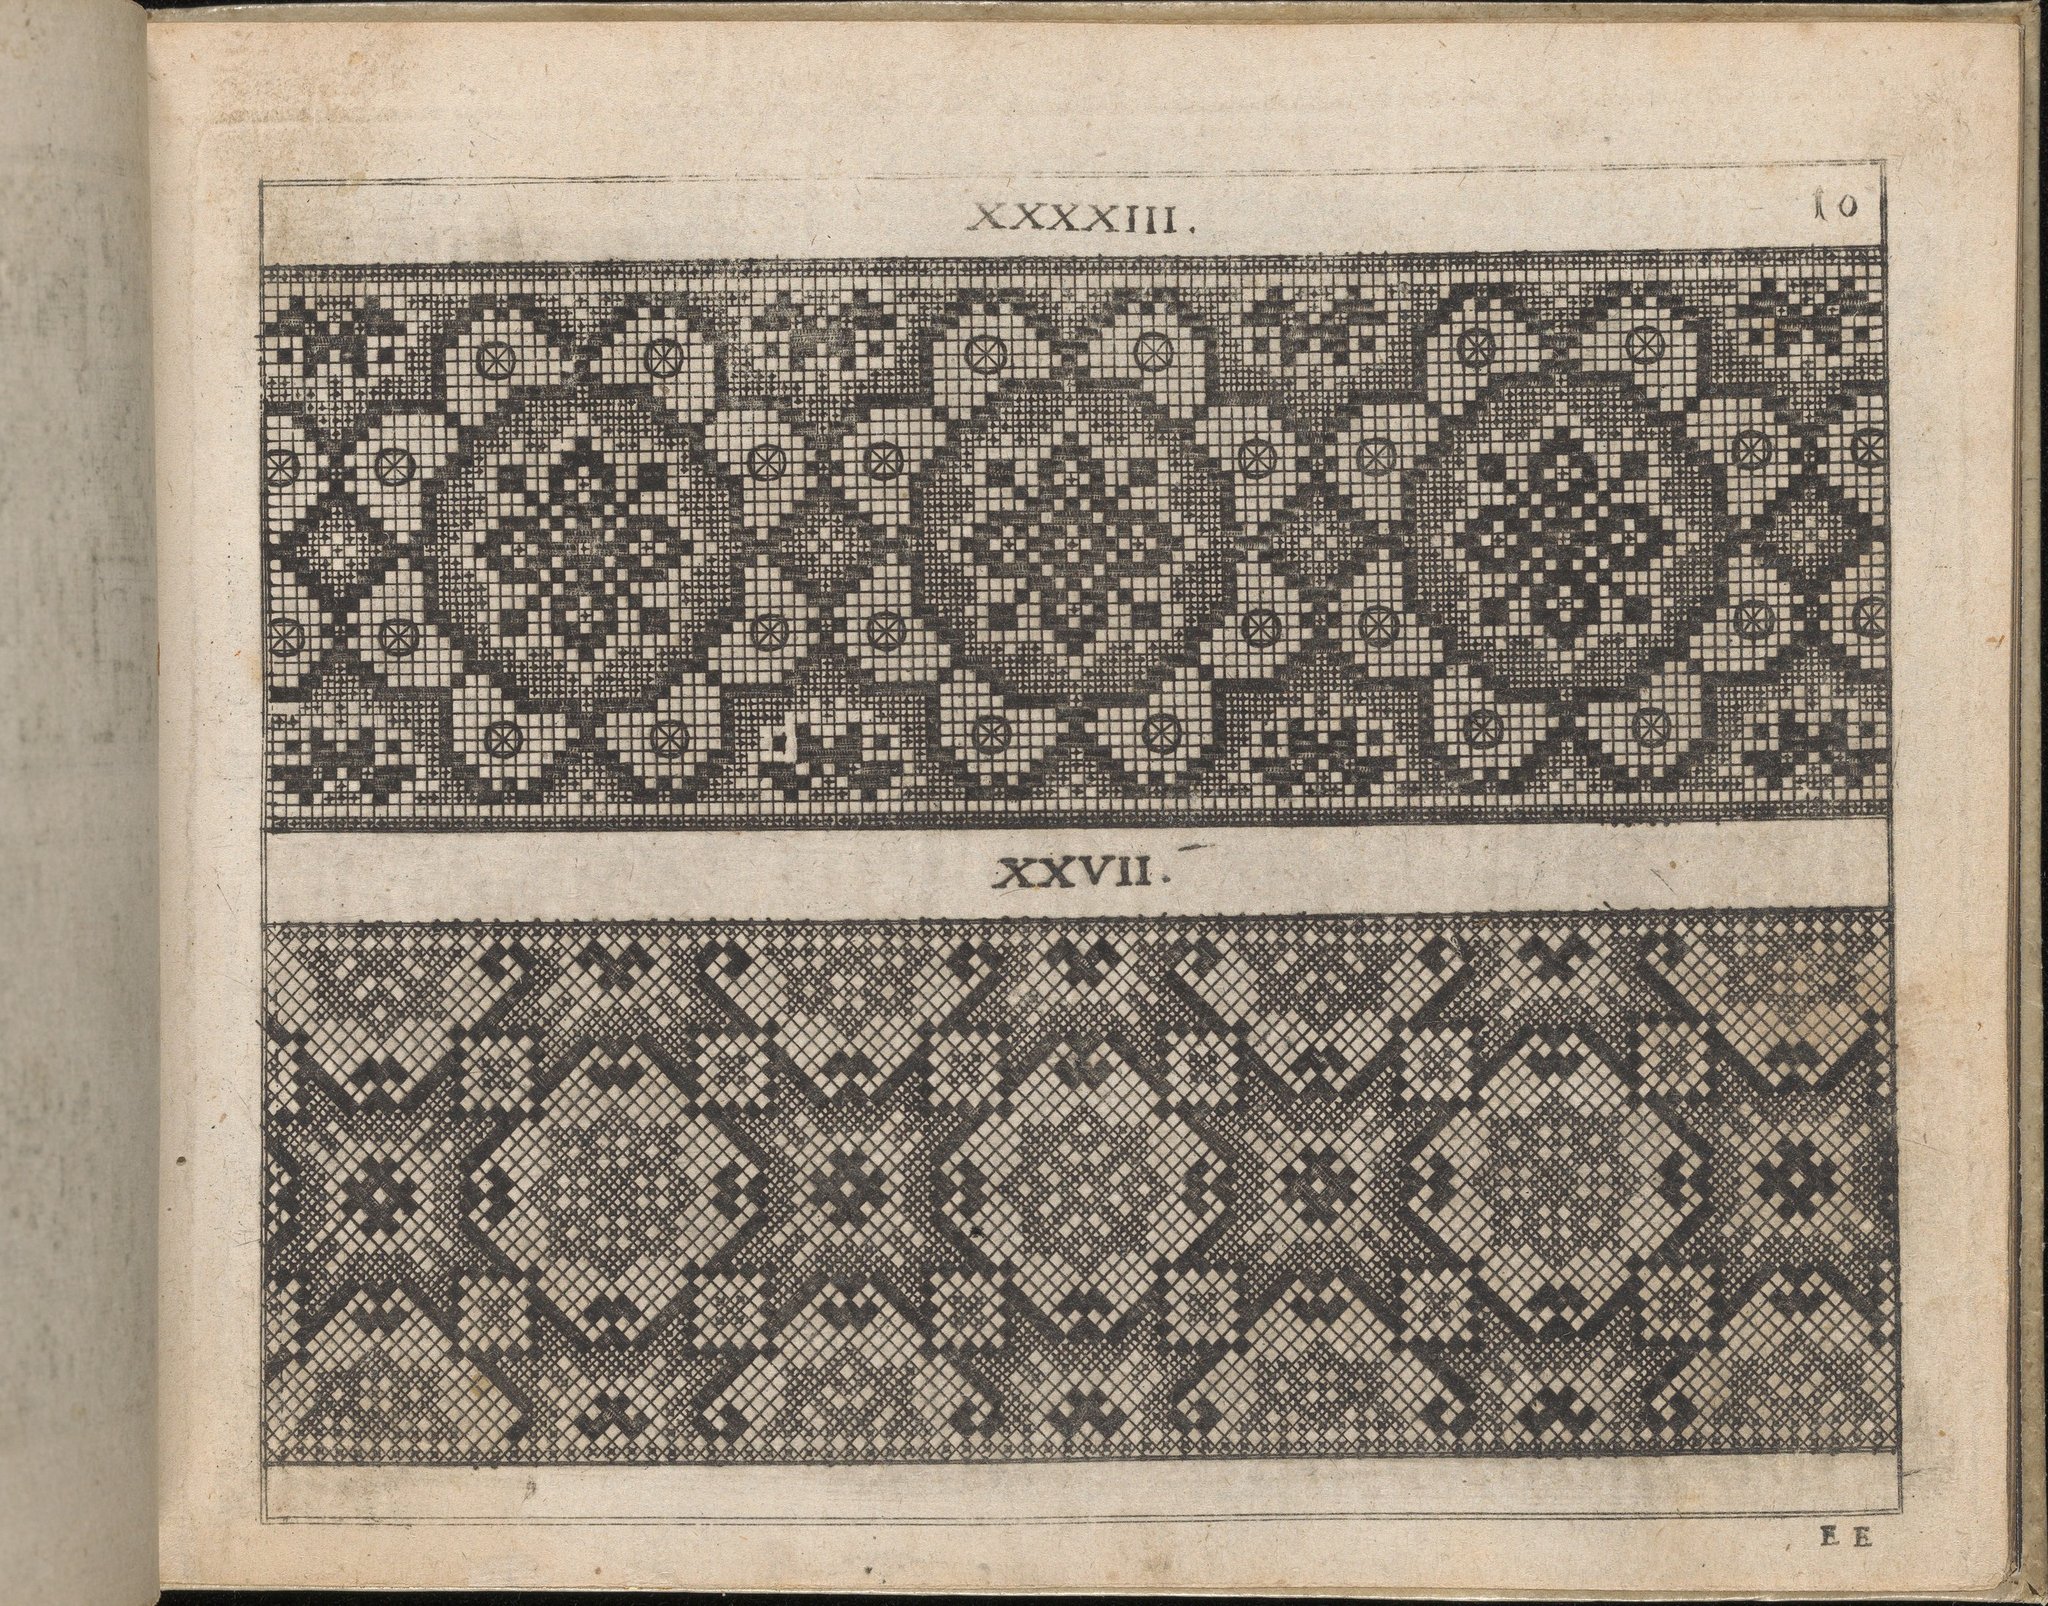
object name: book print ornament architecture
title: Newes Modelbuch in Kupffer (Page 19r)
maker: johann sibmacher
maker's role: artist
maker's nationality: german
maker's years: 1590-1611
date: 1604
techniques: etching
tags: ornament